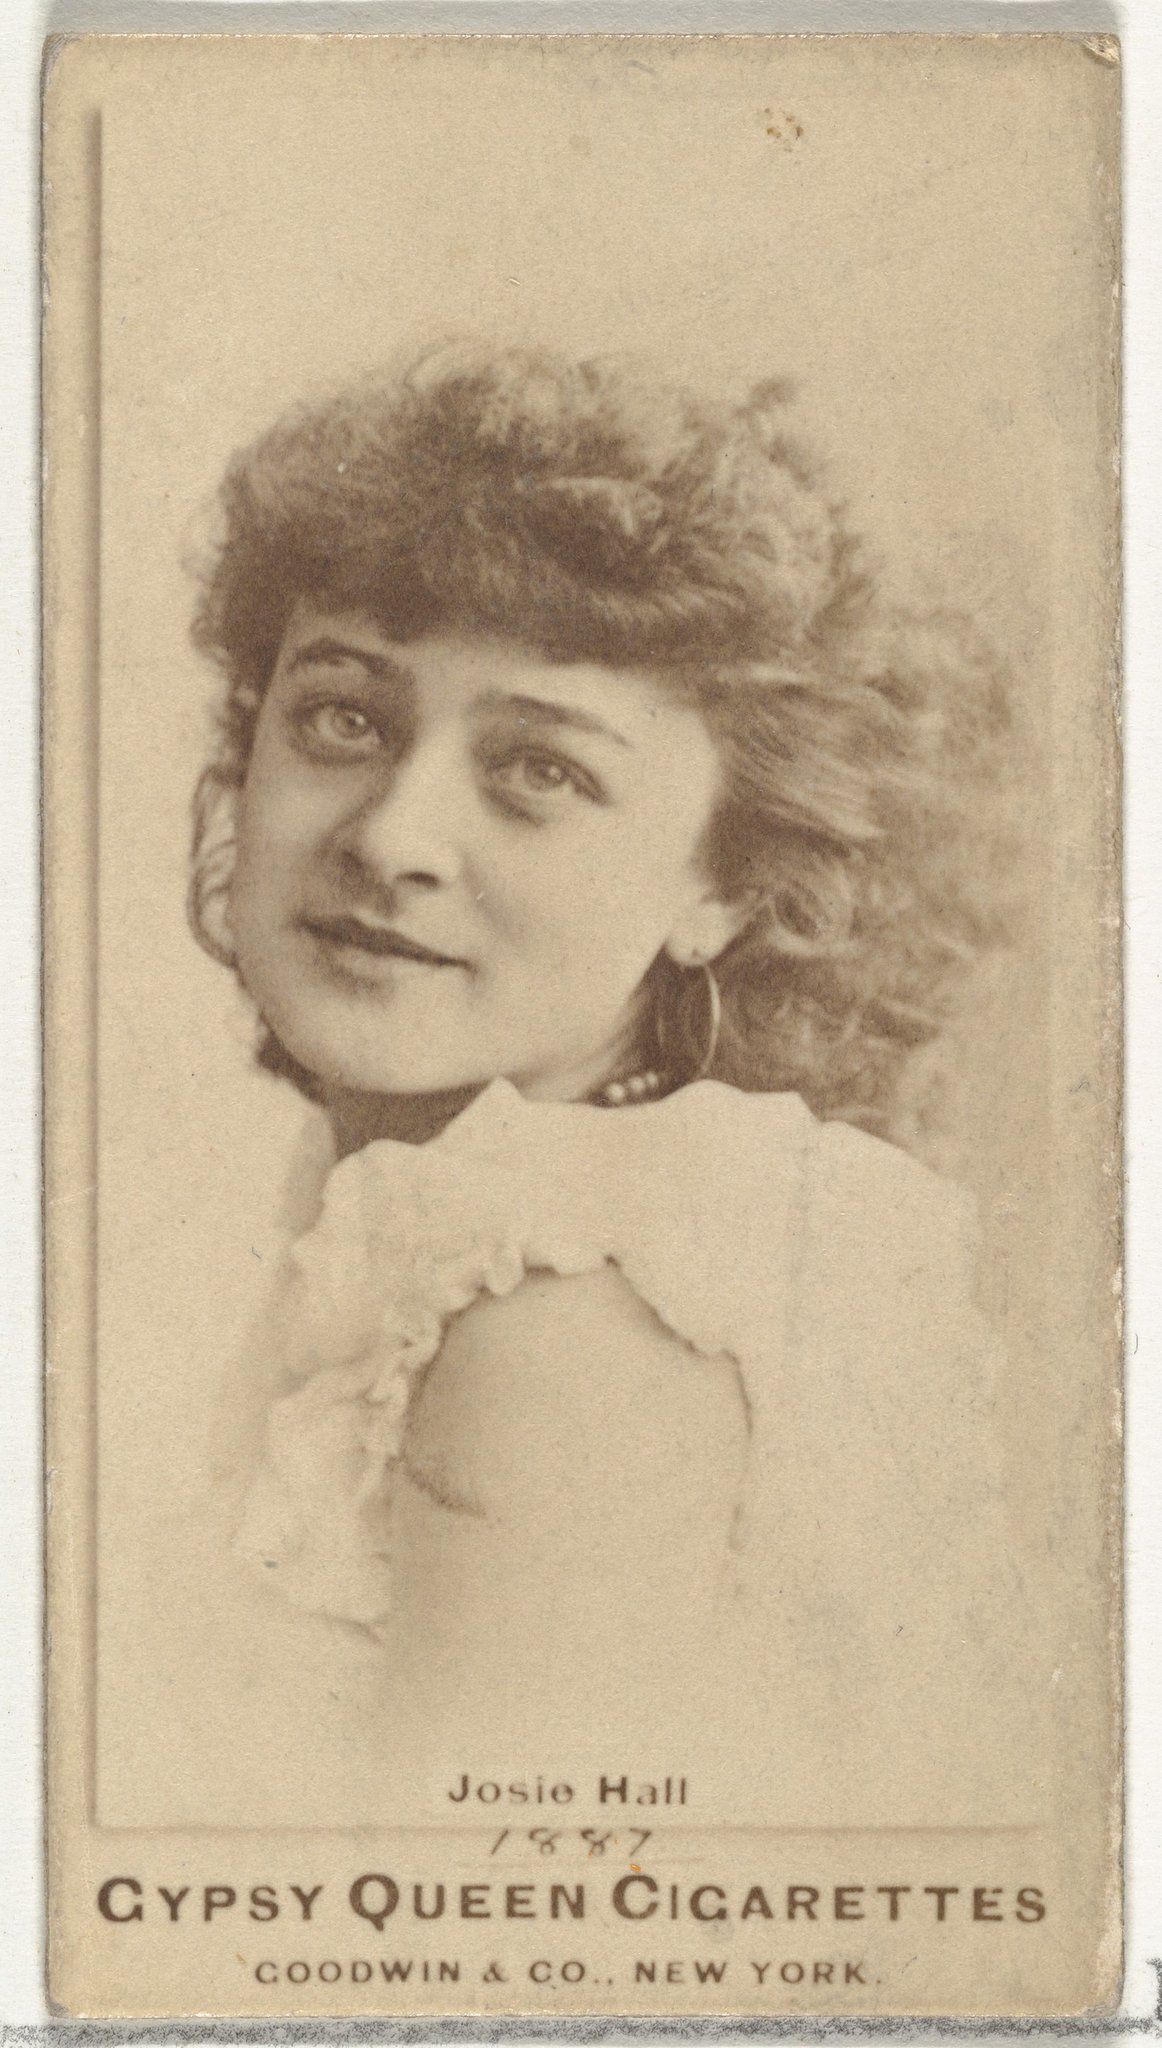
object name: photograph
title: Josie Hall, from the Actors and Actresses series (N171) for Gypsy Queen Cigarettes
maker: goodwin & company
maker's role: publisher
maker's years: 1850-1950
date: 1886-1890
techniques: albumen silver print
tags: portraits,women,actresses